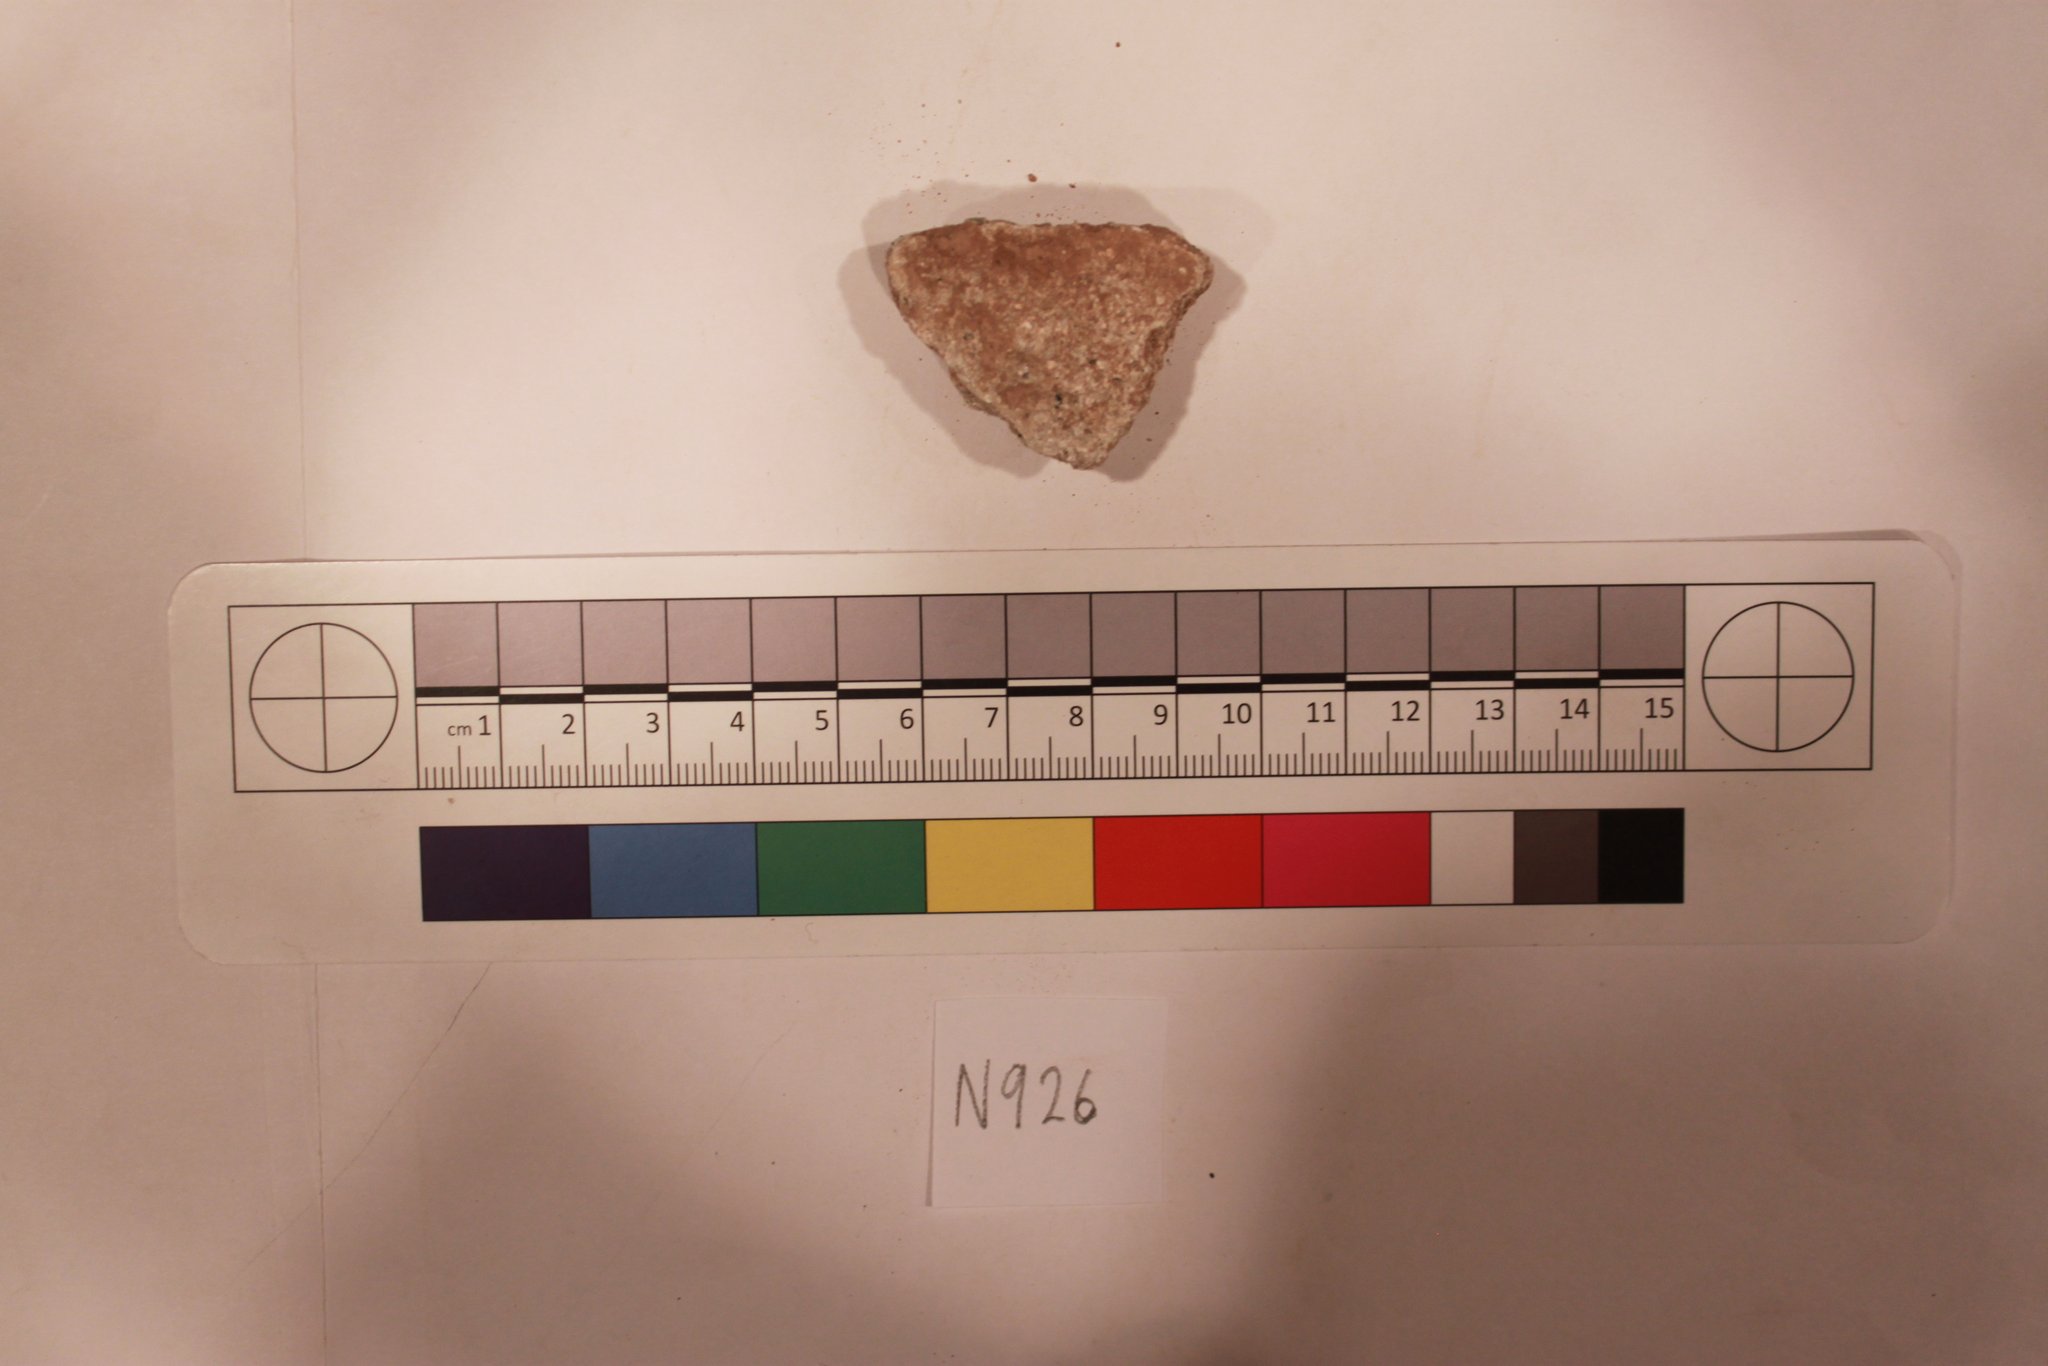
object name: fragment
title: Stucco Fragment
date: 701-1200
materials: plaster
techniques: carving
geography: iran